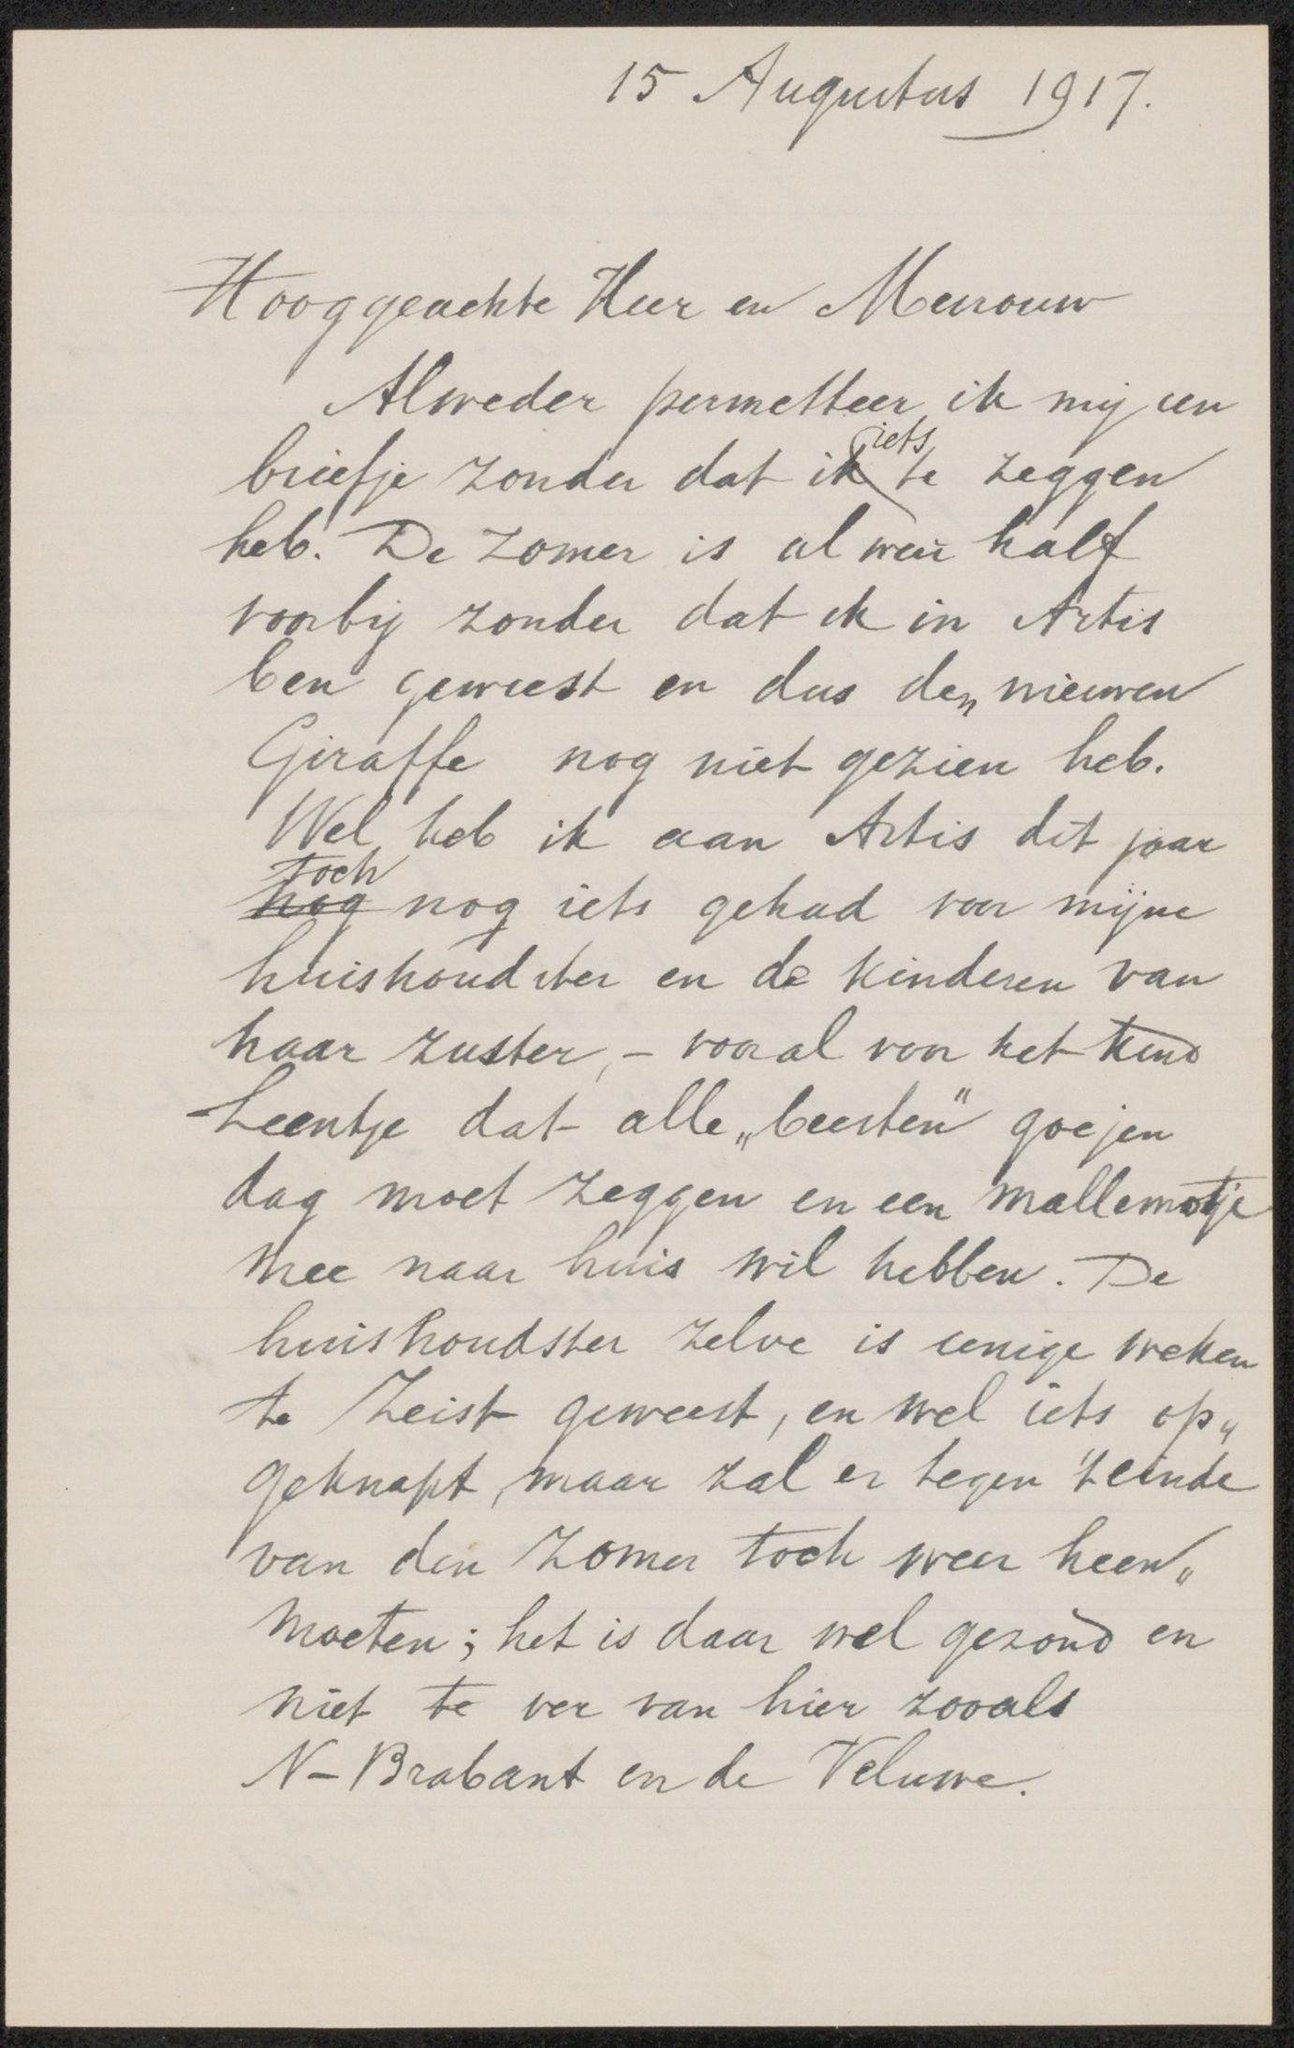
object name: letter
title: Brief aan Max Wilhelm Carl Weber en Anne Antoinette Weber-Van Bosse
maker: august allebé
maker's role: draughtsman, print maker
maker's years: 1838-1927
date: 1917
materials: ink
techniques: pen, writing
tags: anne antoinette weber-van bosse, painter, print maker, draughtsman, jac van looij, literature ~ arts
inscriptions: watermark